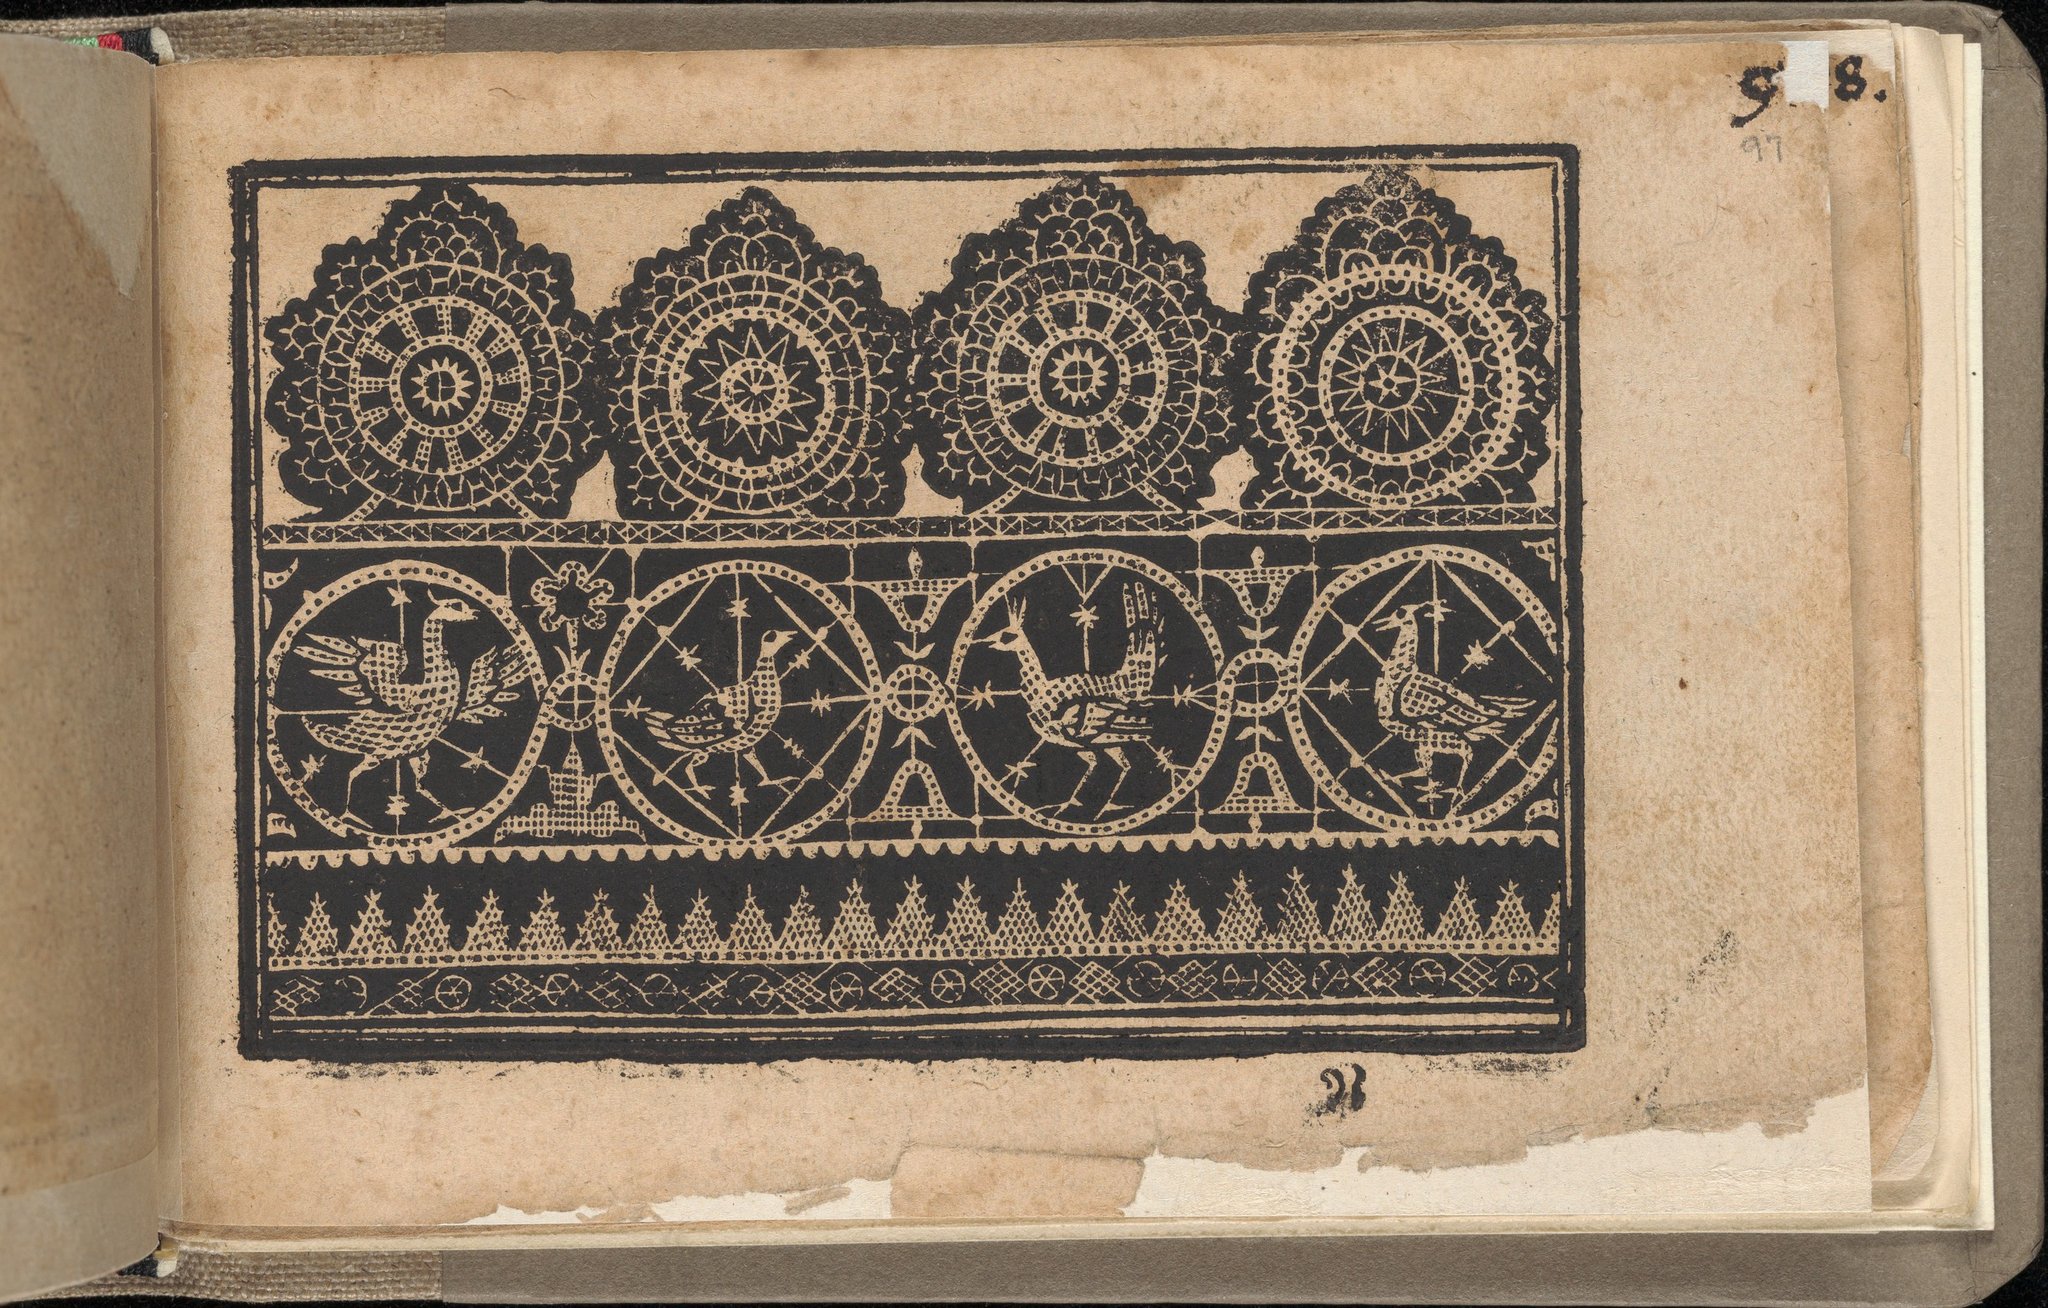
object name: book print ornament architecture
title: Schön newes Modelbuch (Page 97r)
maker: sigismundus latomus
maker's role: publisher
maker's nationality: german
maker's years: 1599-1632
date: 1608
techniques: woodcut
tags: birds,ornament